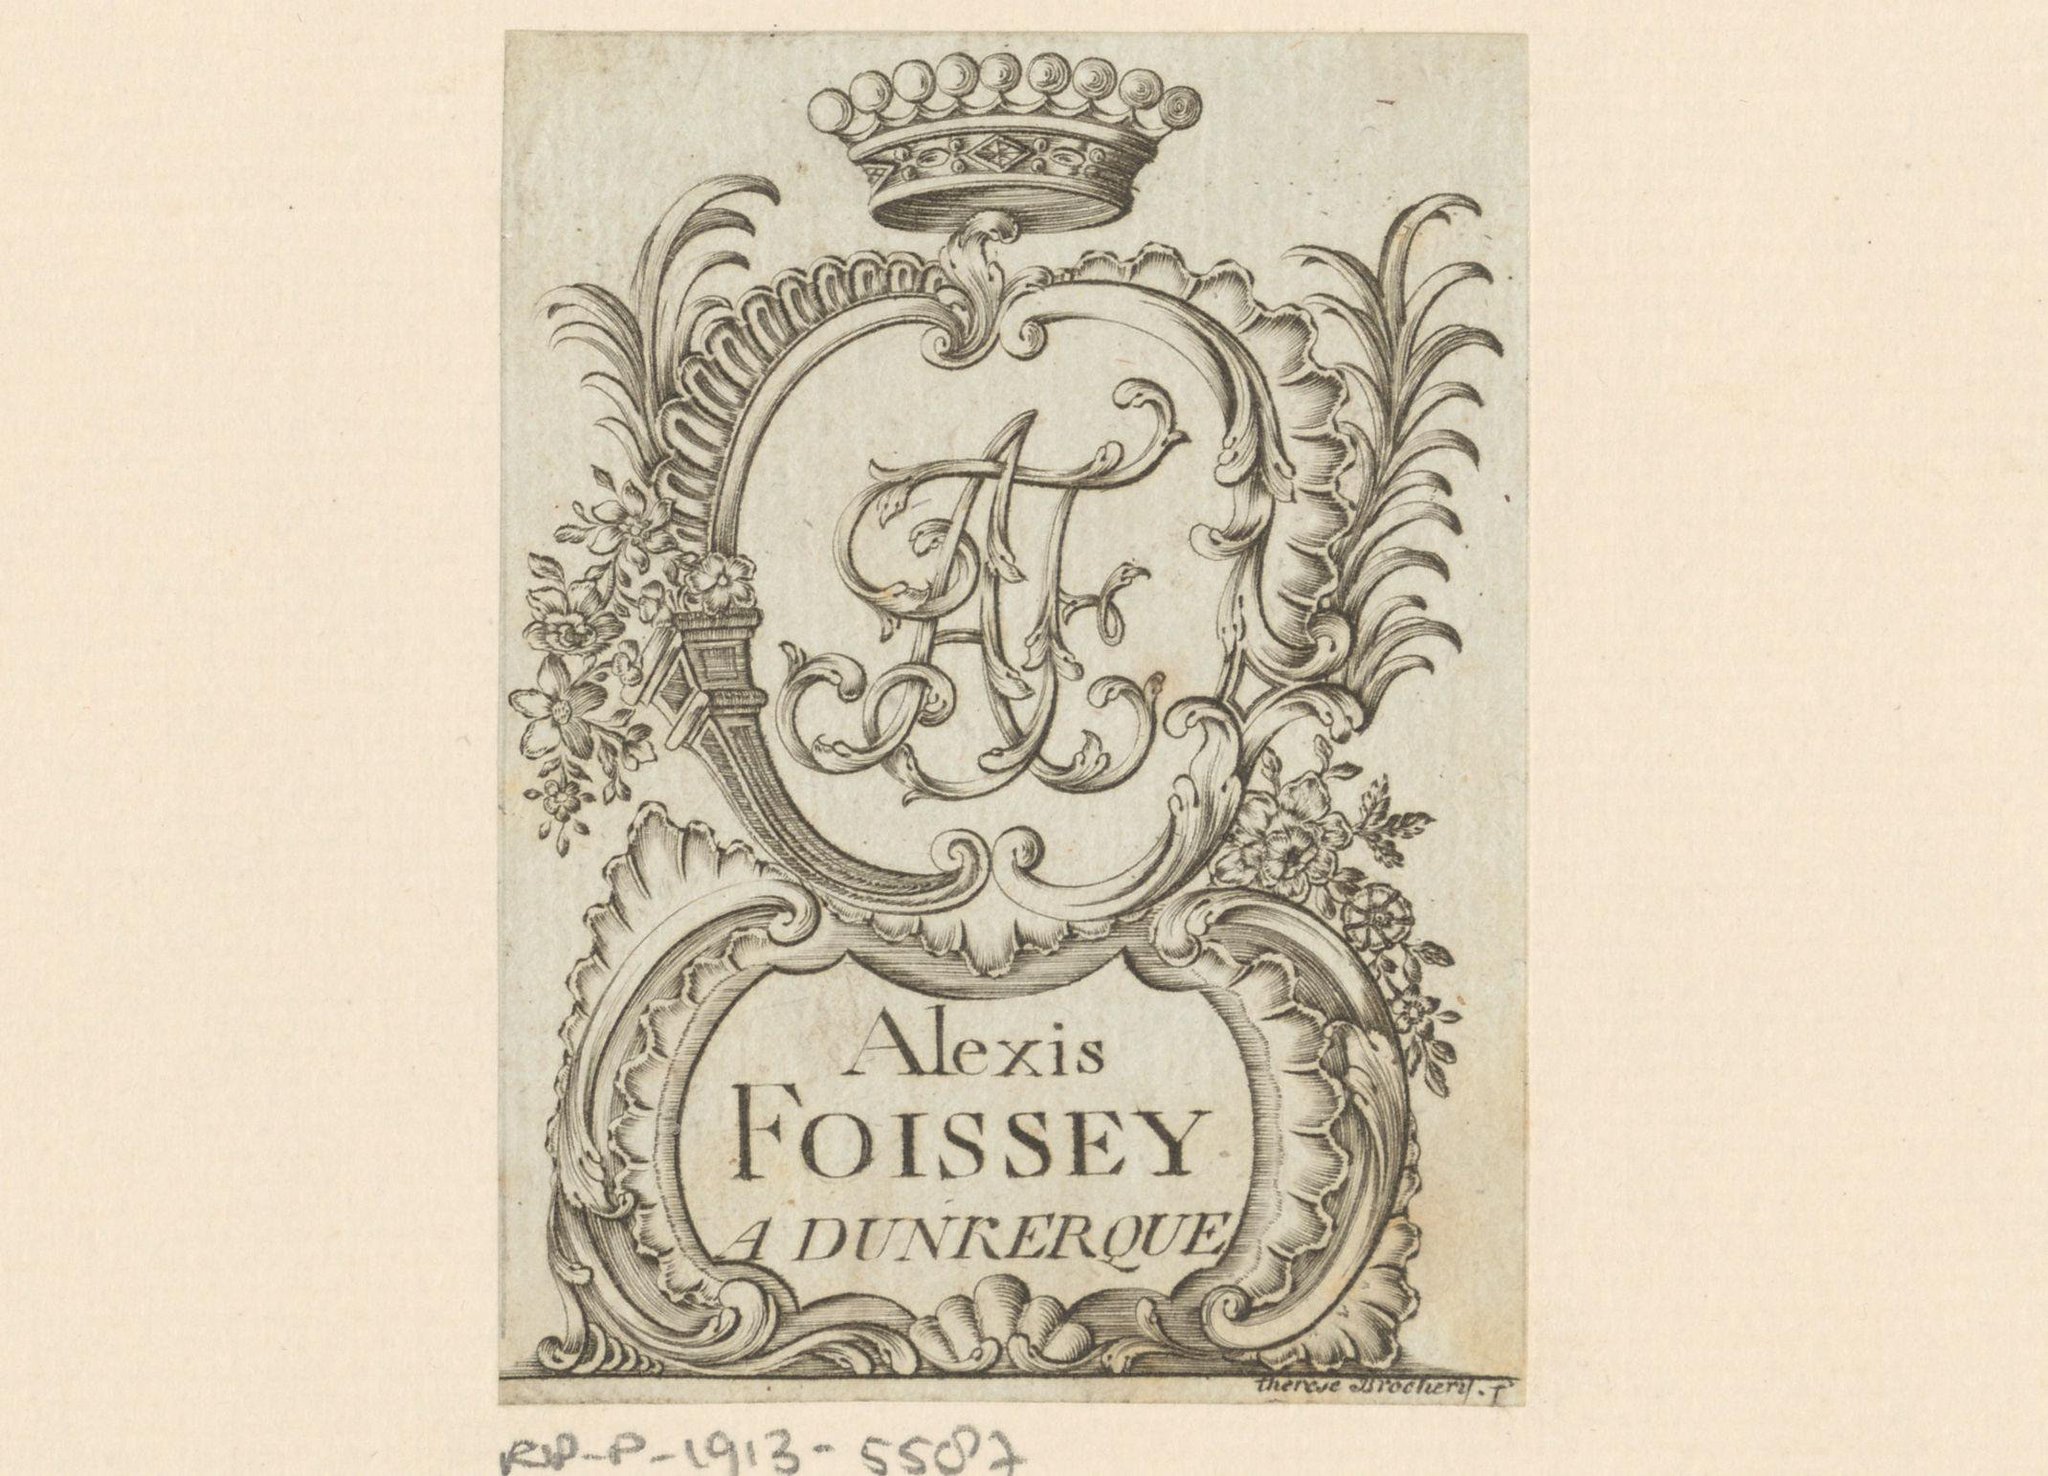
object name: bookplate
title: Ex libris van Alexis Foissey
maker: thérèse brochery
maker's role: print maker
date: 1700-1799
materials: paper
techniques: engraving, etching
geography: france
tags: flowers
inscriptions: collector's mark: Lugt 2233, collector's mark: Lugt 2760